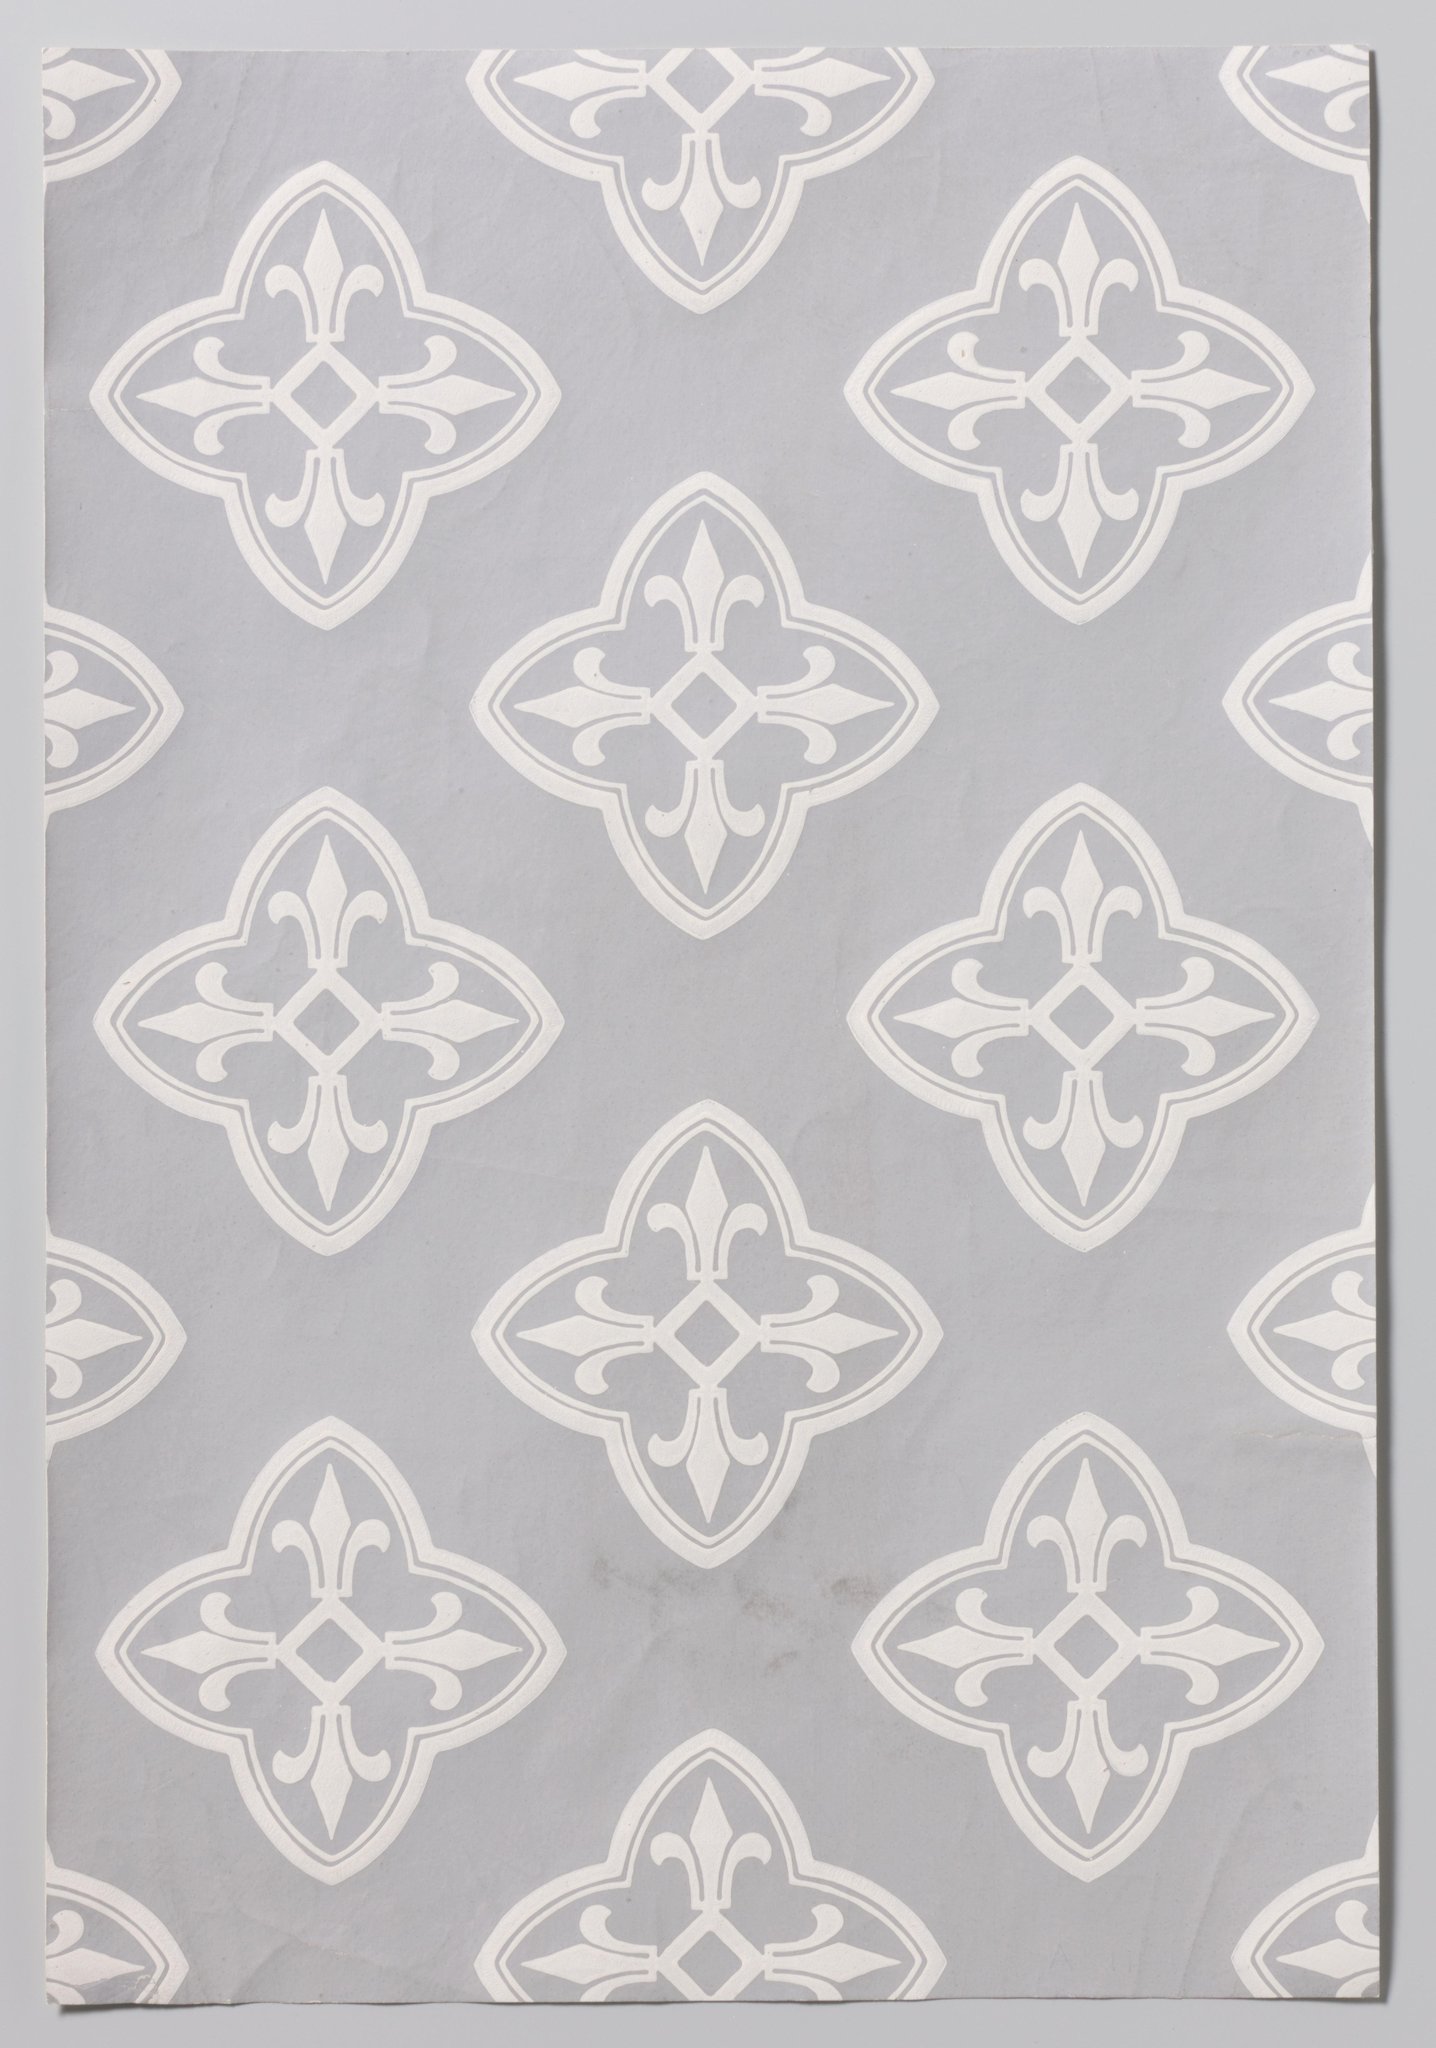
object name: wallpaper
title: Papierbehangsel met patroon van vierpassen en Franse lelies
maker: jules desfossé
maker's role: behangselfabrikant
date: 1851-1855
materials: paper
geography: paris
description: Papierbehangsel met een patroon van witte vierpassen met daarin een witte kruisvorm, die is samengesteld uit Franse lelies, op een grijs fond. Blokdruk met doorlopend patroon op een gesatineerd fond.